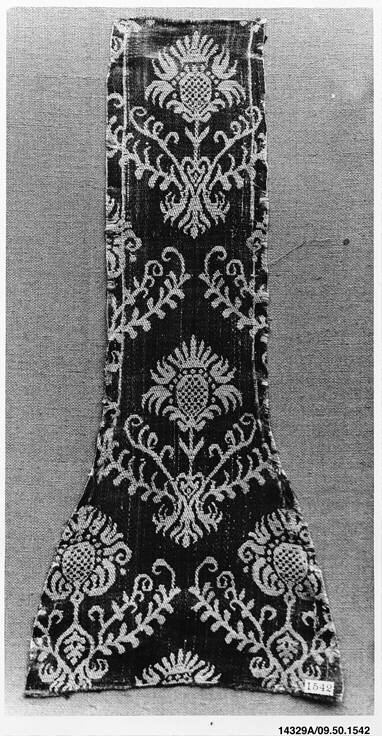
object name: fragment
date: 1701-1800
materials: cotton, silk